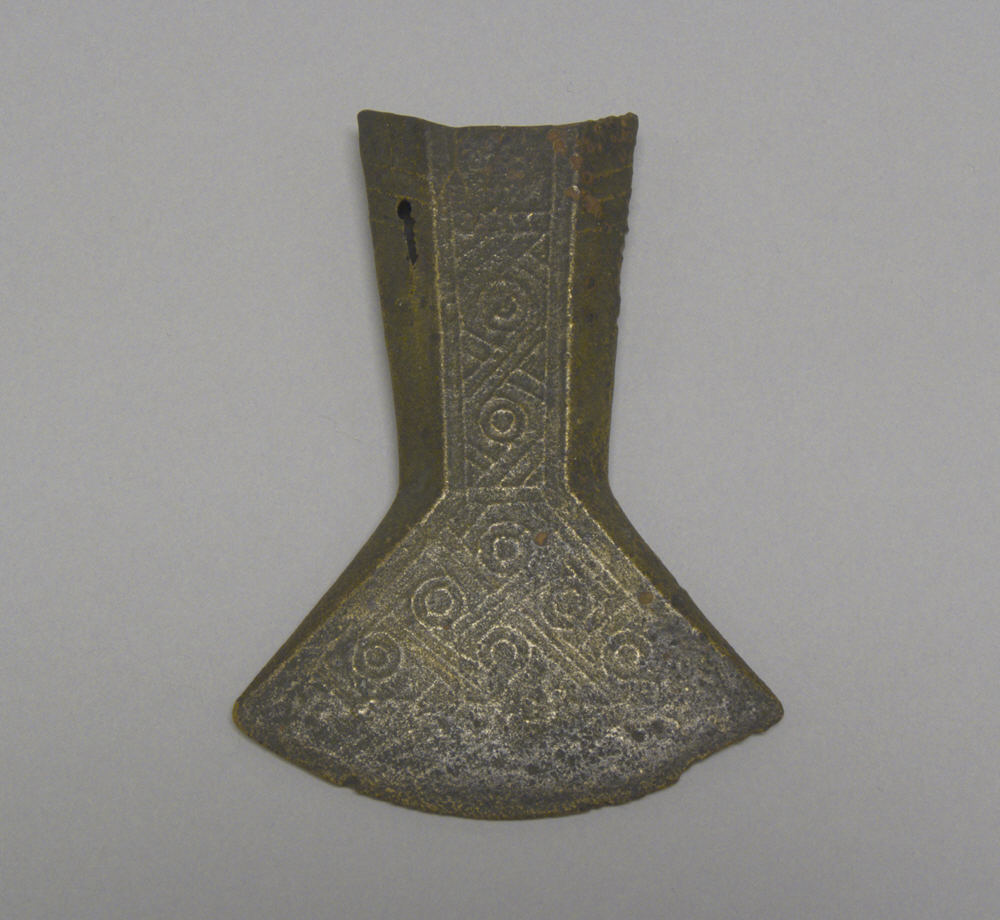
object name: hafted ax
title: Hafted Fan-Shaped Ax with Design of Lattice and Circles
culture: indonesian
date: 500 BCE-300 CE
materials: bronze